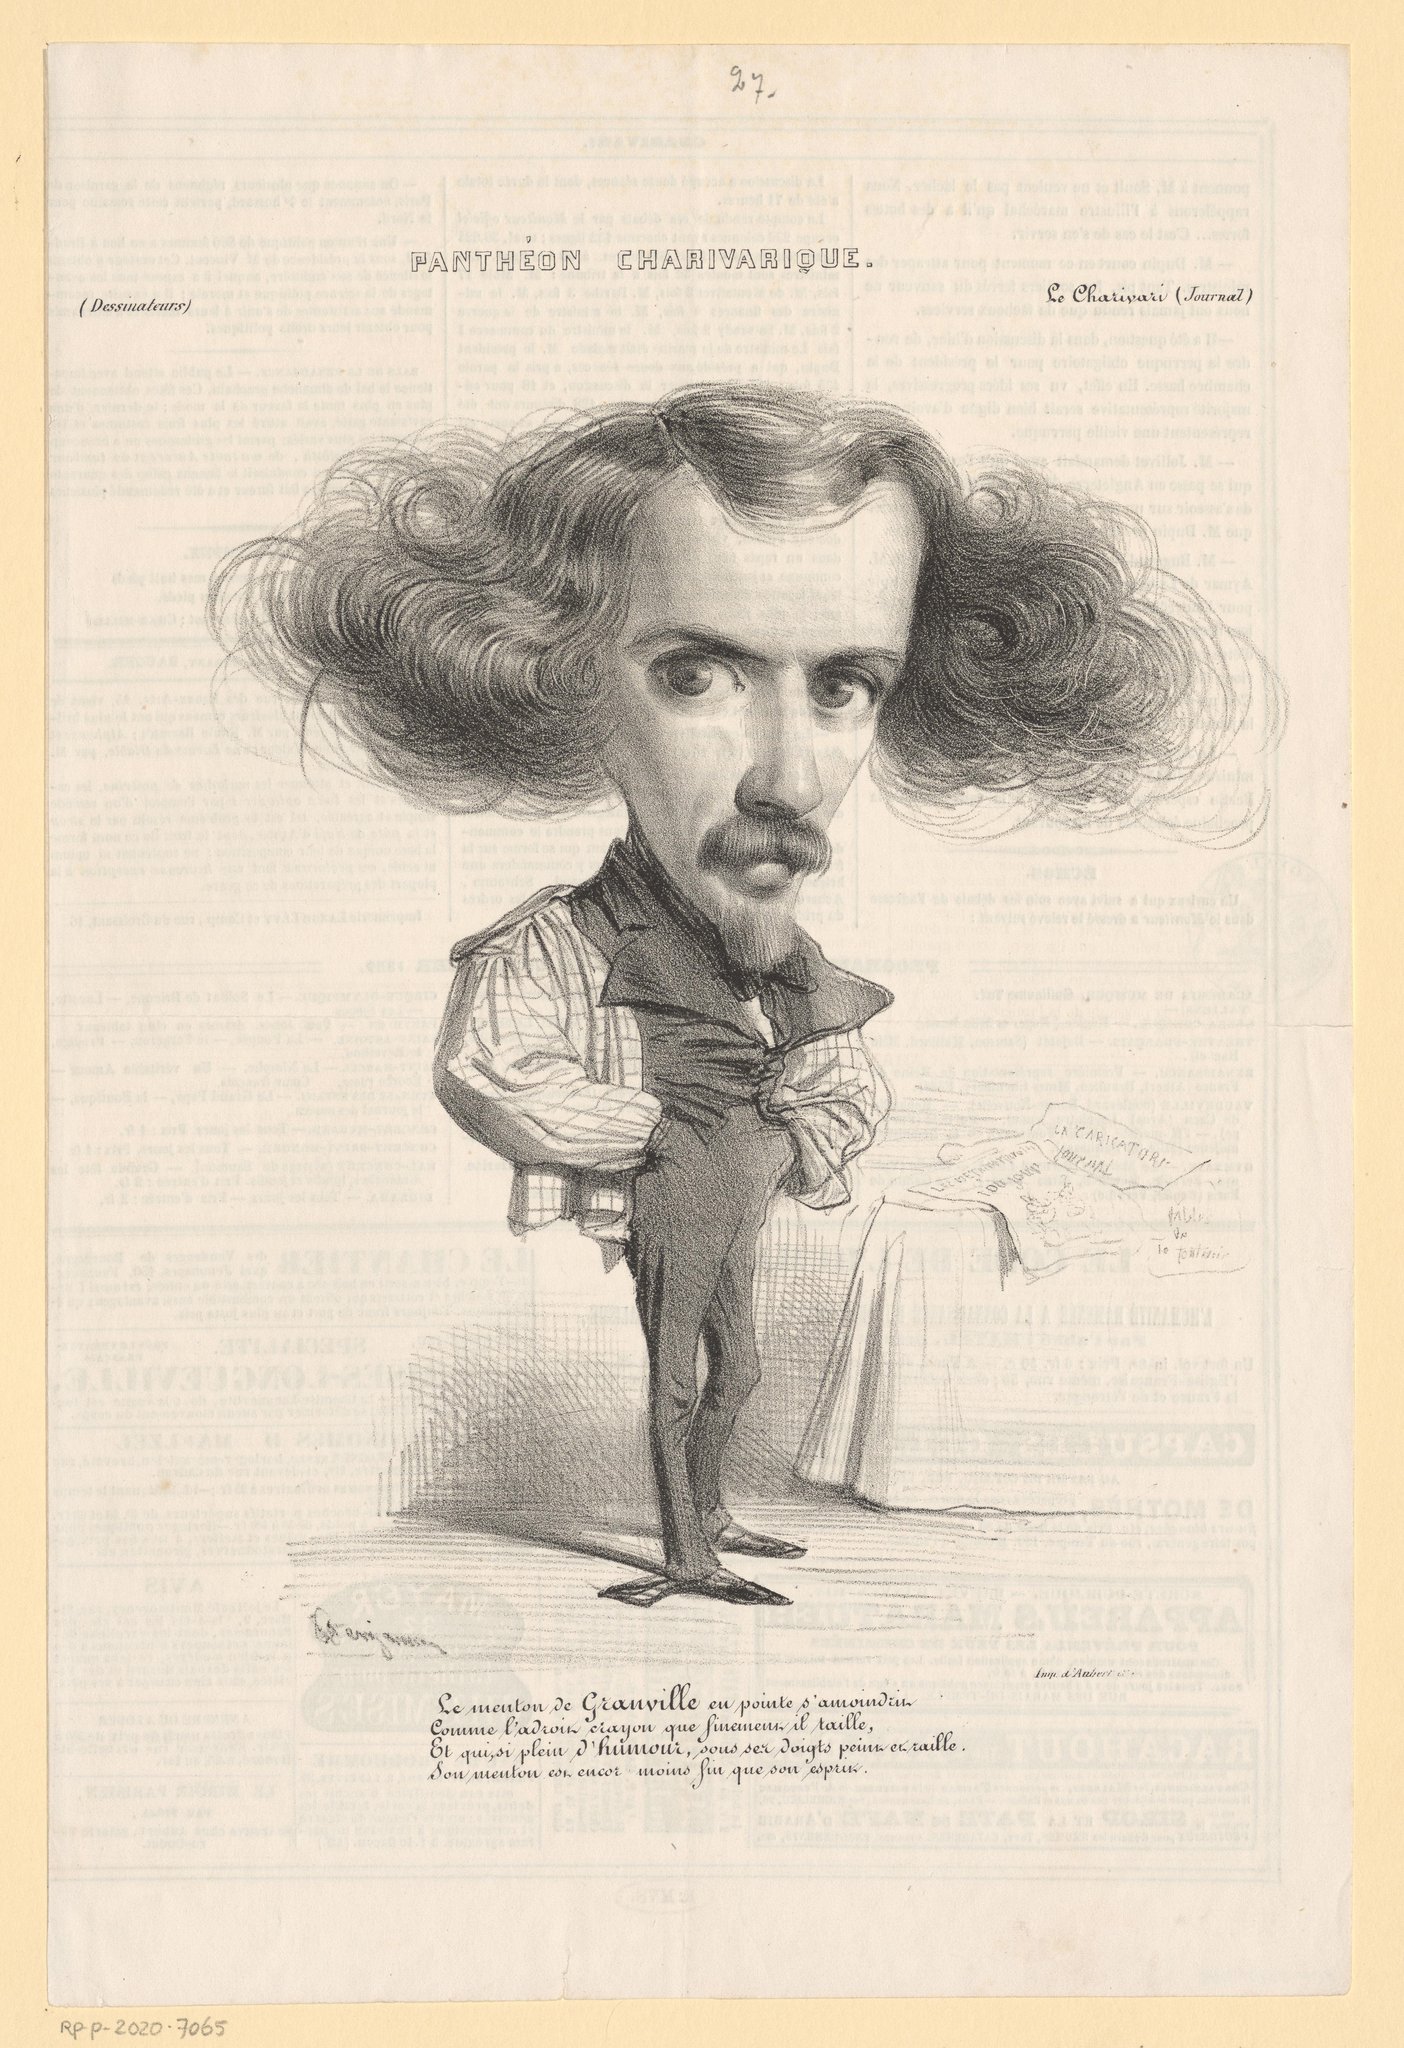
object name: cartoon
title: Panthéon Charivarique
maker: benjamin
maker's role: print maker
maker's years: 1811-1847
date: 1839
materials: paper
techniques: letterpress printing, lithograph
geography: paris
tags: print maker, draughtsman, jean ignace isidore gérard grandville, historical persons, portrait, self-portrait of graphic artist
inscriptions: collector's mark: Lugt 2228, stamp: ‘Royal Timbre’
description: Uit de serie: Panthéon charivarique, bestaande uit 100 portretten van tekenaars, schrijvers, schilders, beeldhouwers, musici en acteurs. Prent uit: Le Charivari 25 (1838), nr. 359, 25 januari 1839.